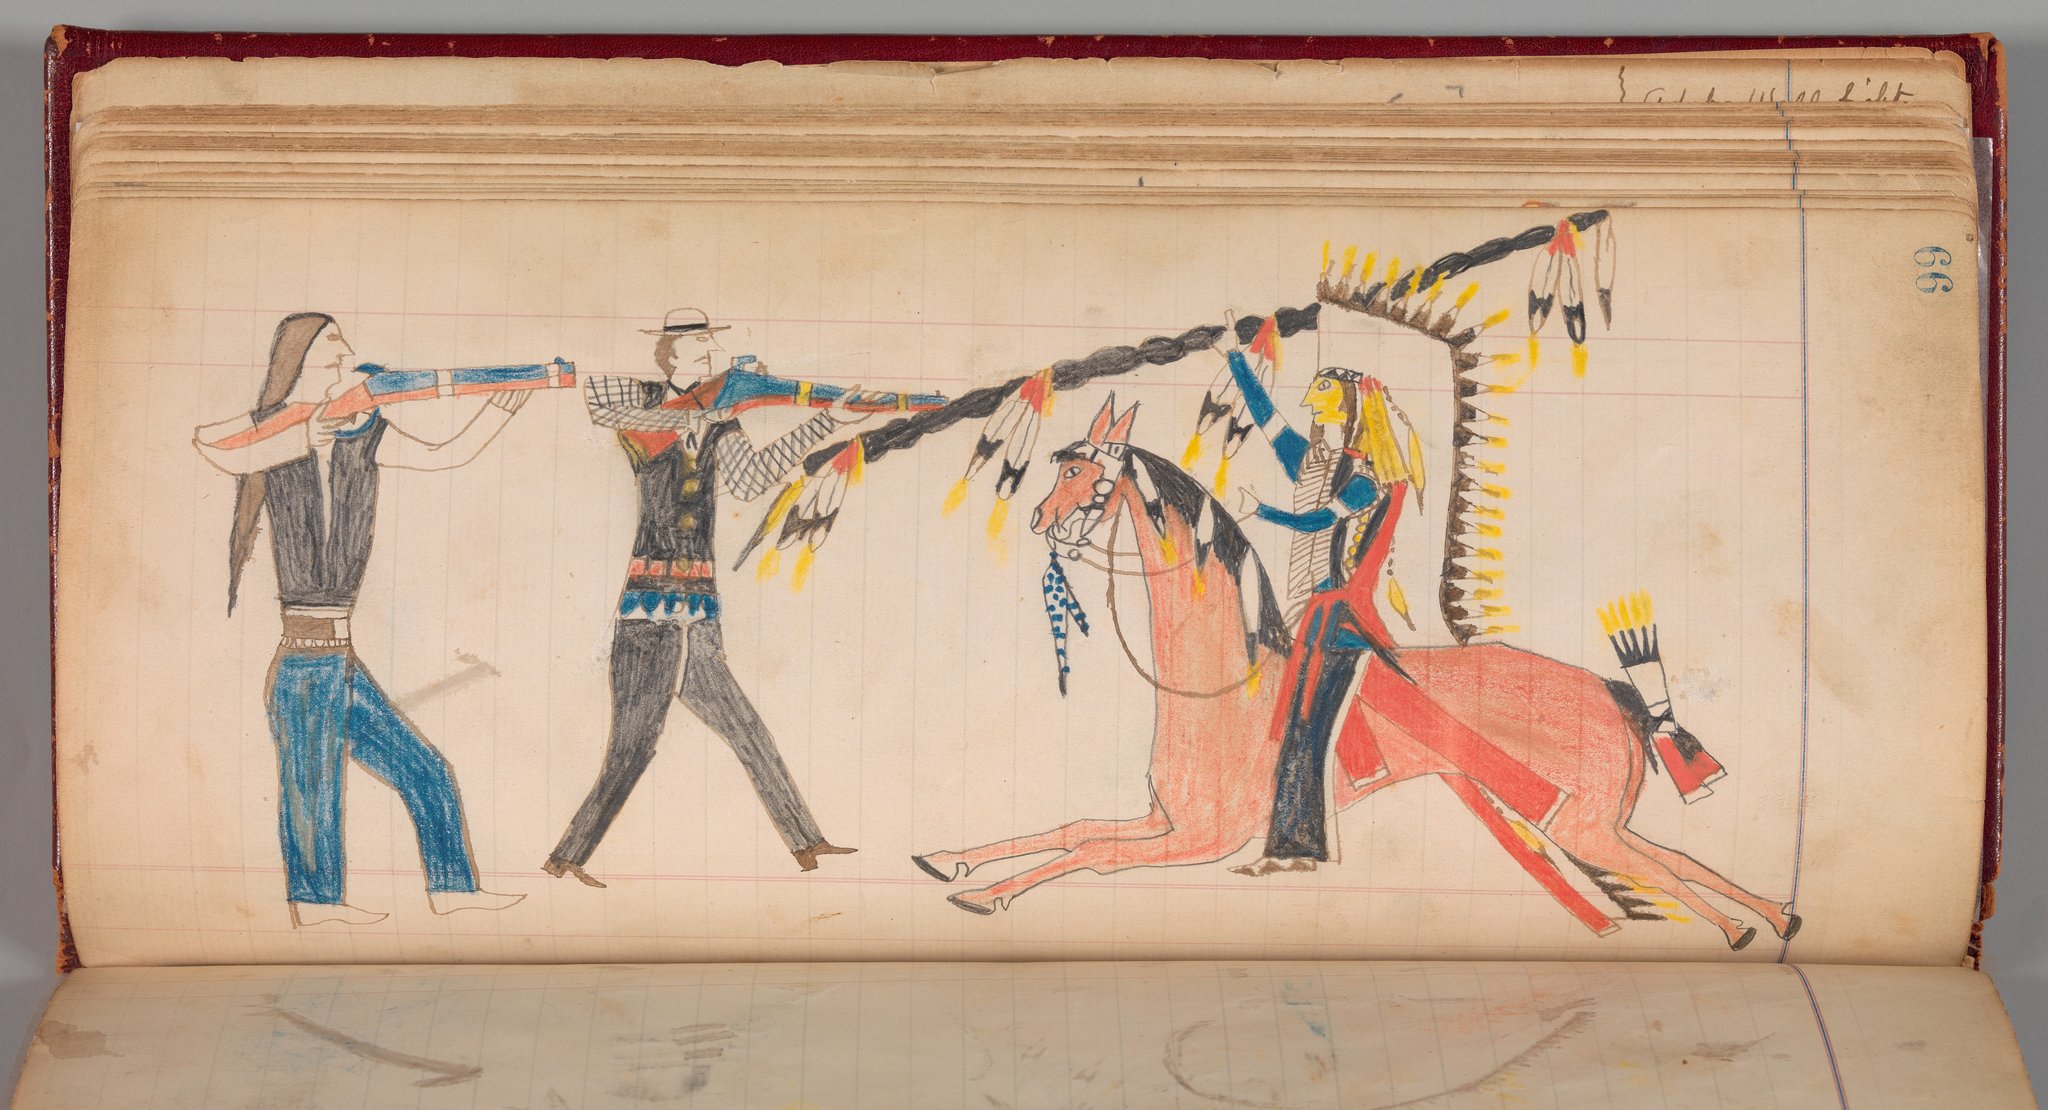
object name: drawing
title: Maffet Ledger: Drawing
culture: cheyenne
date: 1874-1881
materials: crayon, graphite, paper, watercolor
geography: united states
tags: firearms,men,horses